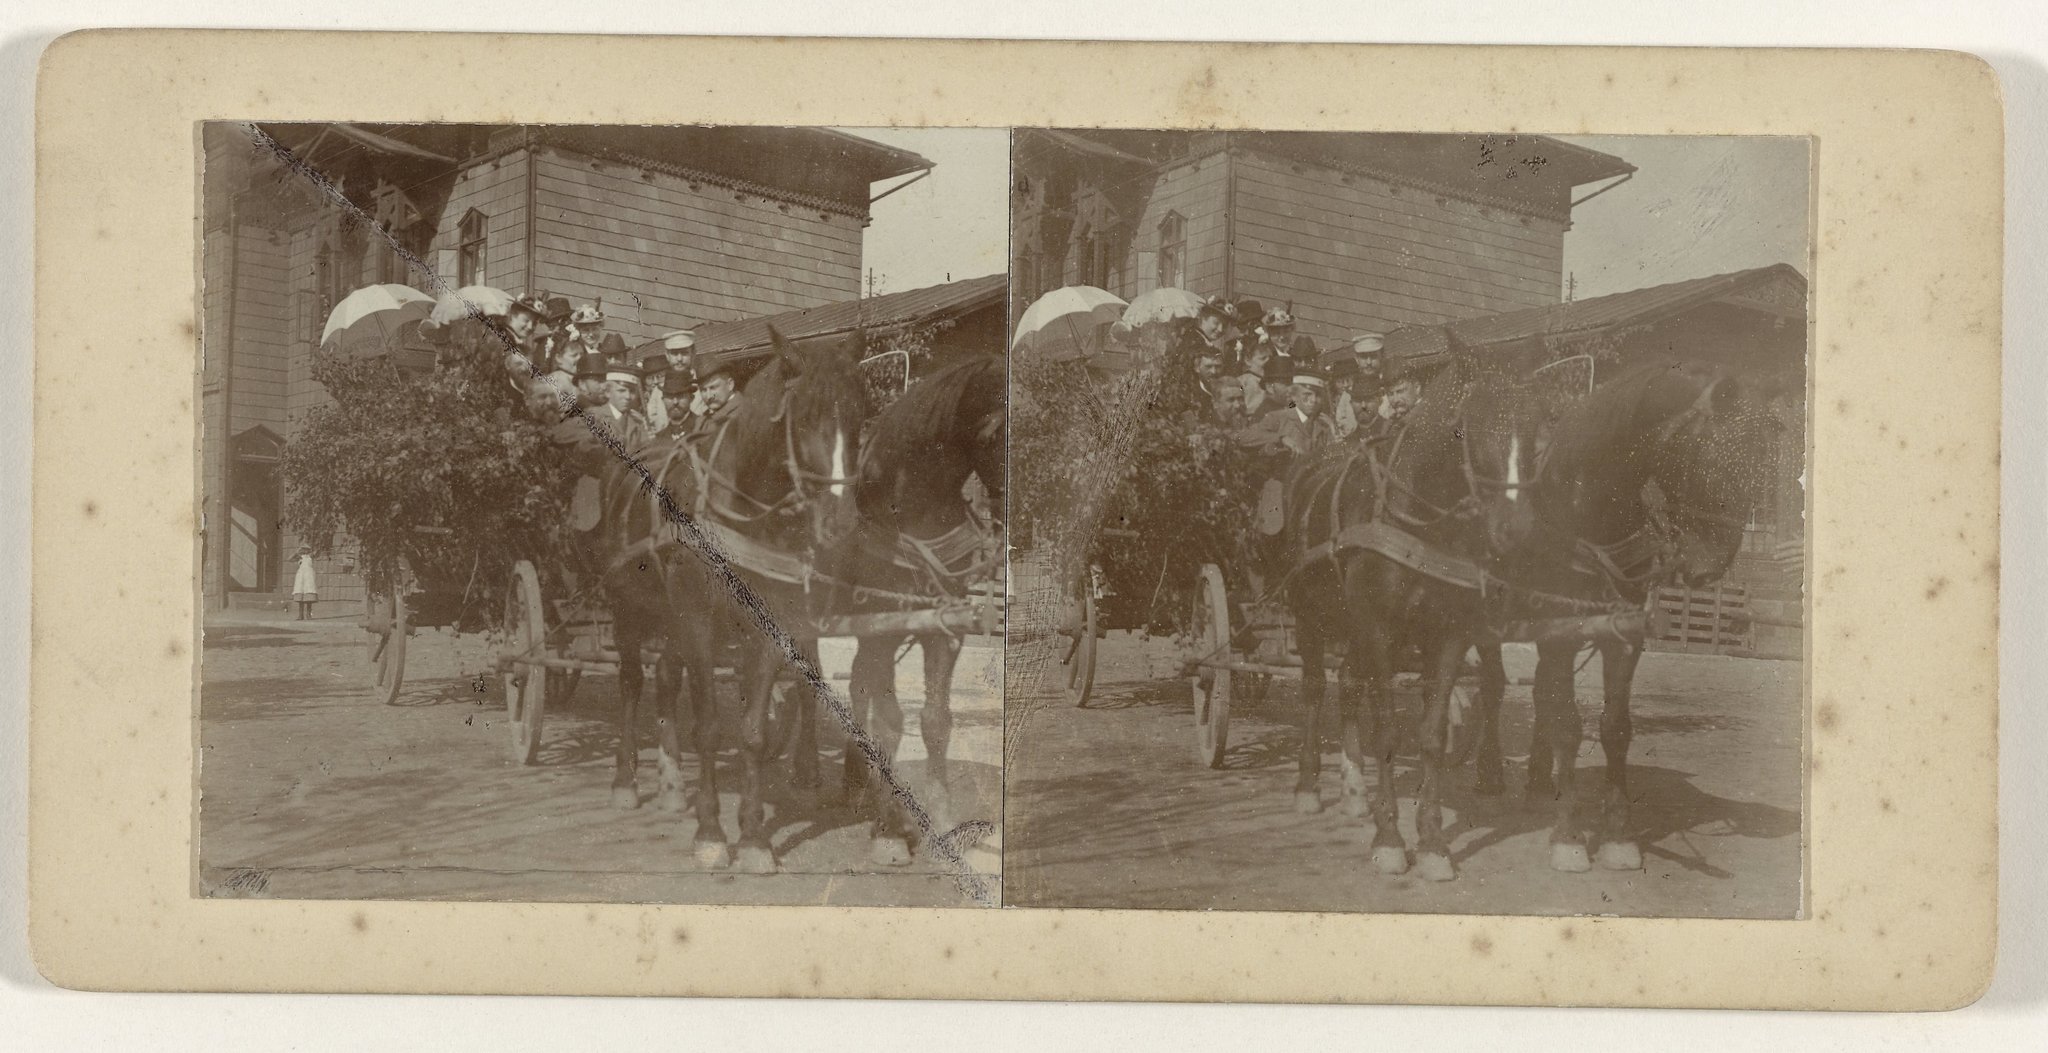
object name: stereograph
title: Rijtuig met passagiers, versierd met planten en voortgetrokken door paarden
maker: geldolph adriaan kessler (dolph)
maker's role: fotograaf, industrieel, voetballer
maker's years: 1884-1945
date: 1895-1903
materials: paper, photographic support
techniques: collodion silver print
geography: netherlands